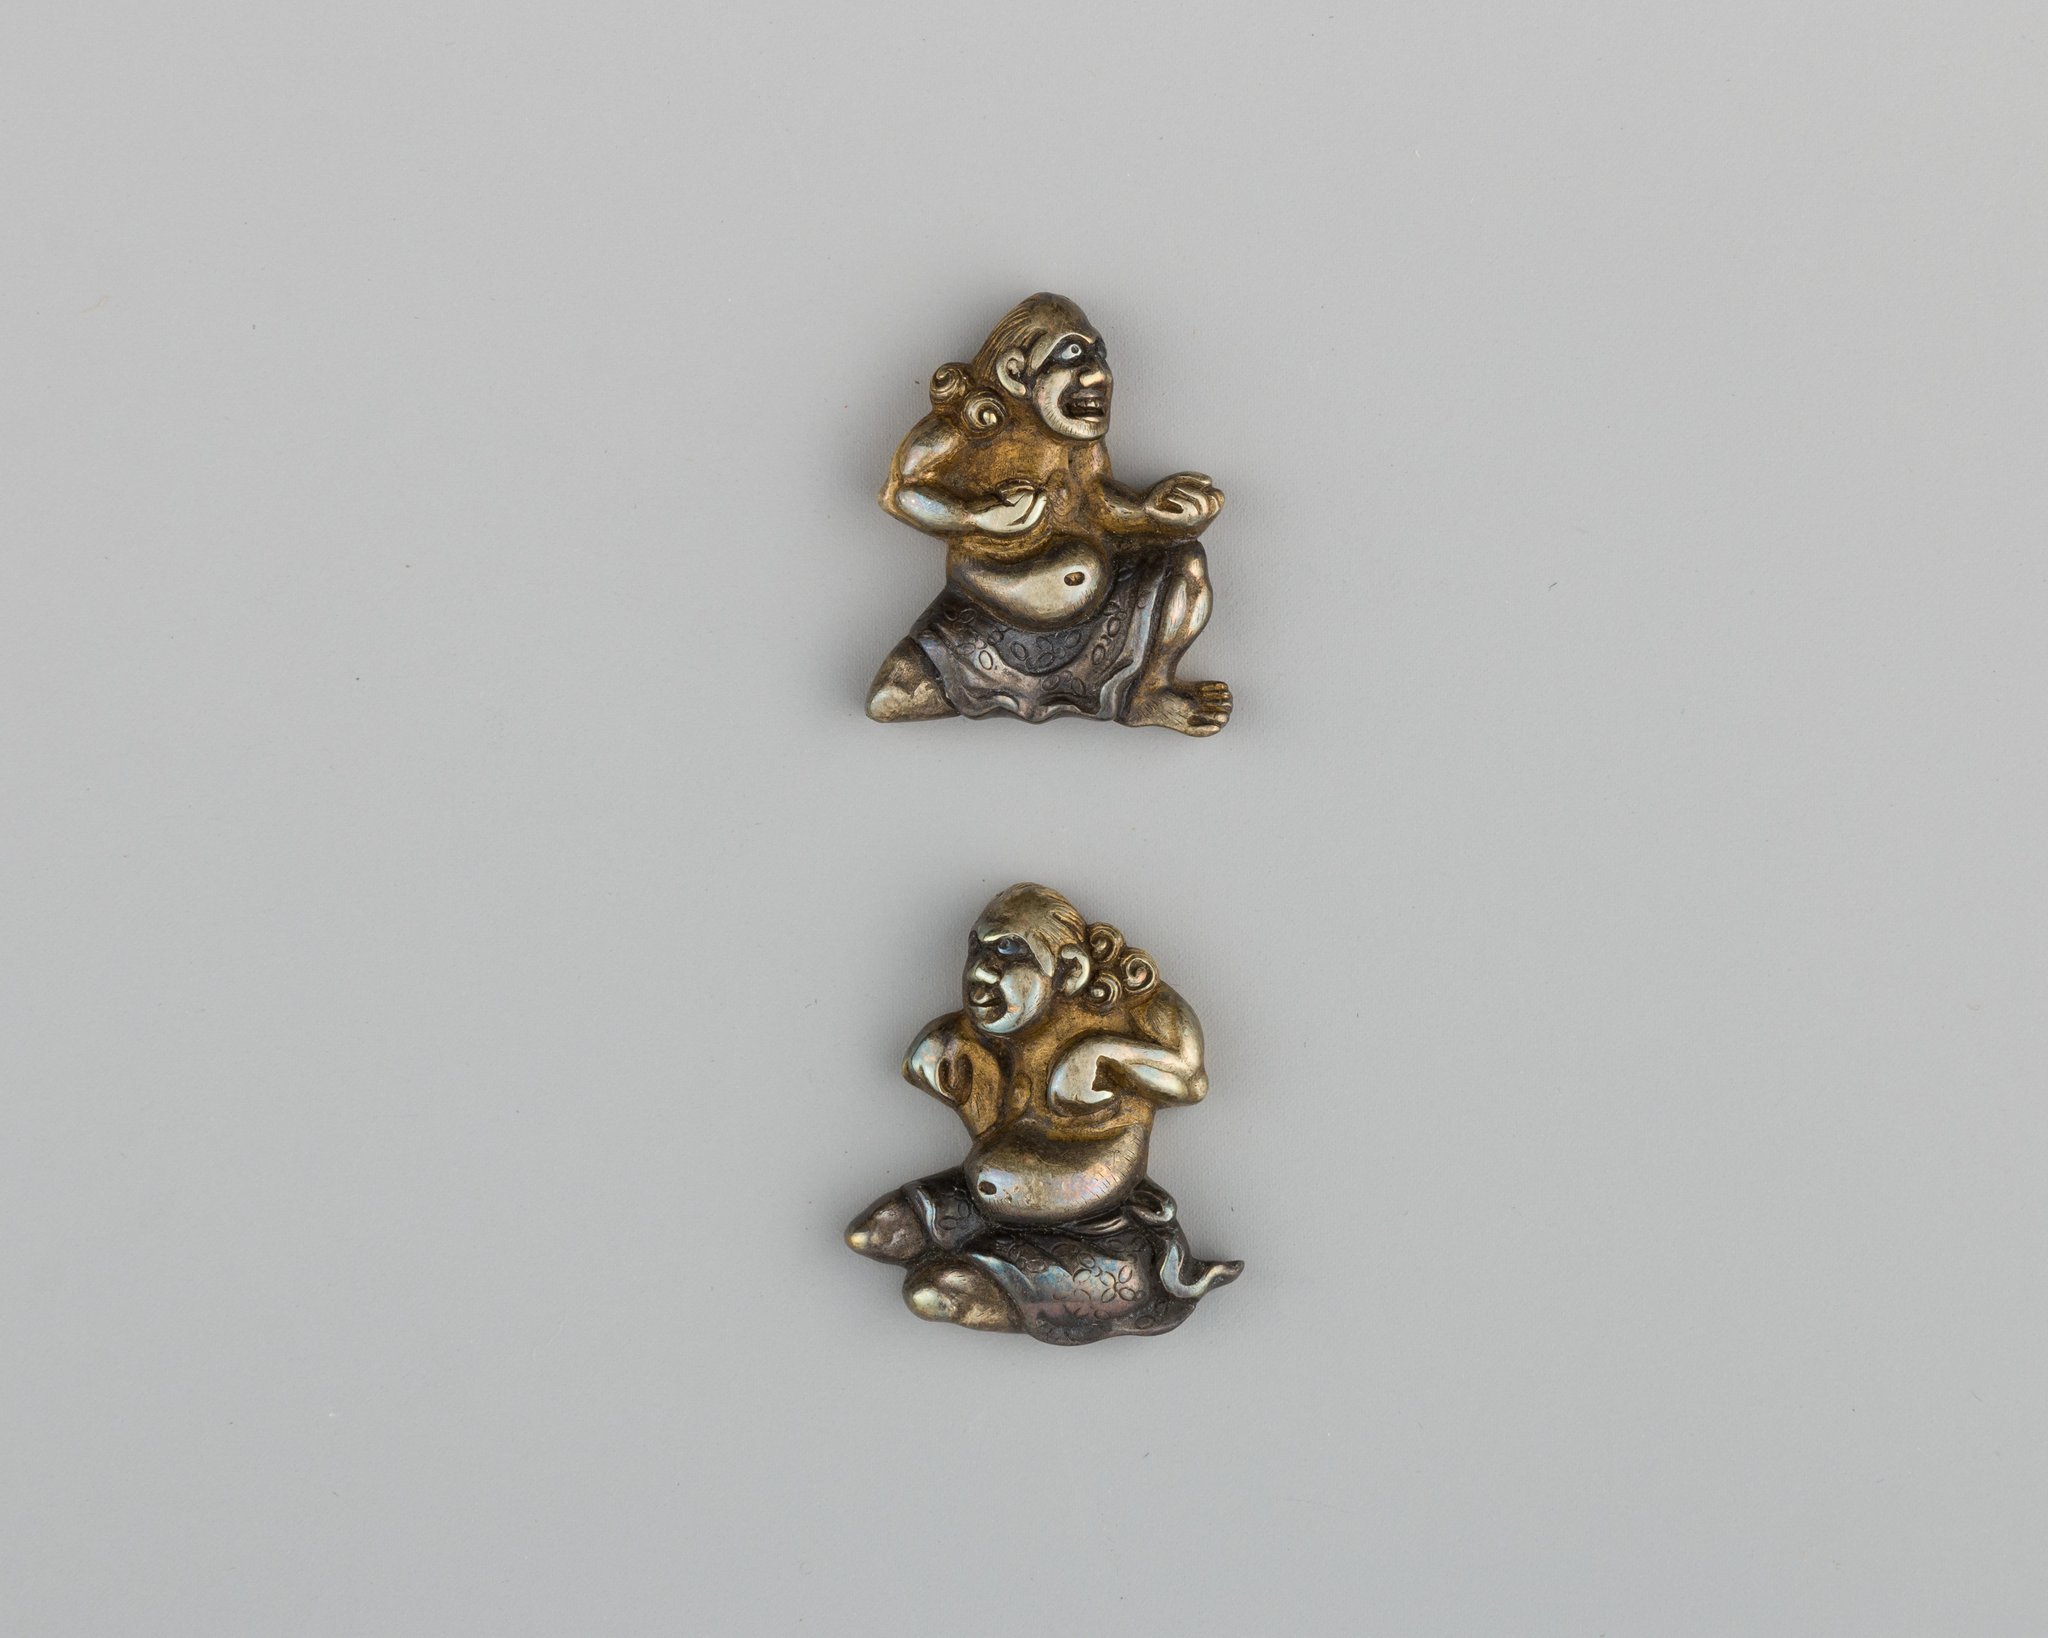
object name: pair of sword grip ornament menuki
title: Pair of Sword-Grip Ornaments (Menuki)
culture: japanese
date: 1701-1800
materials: gold, silver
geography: japan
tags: men